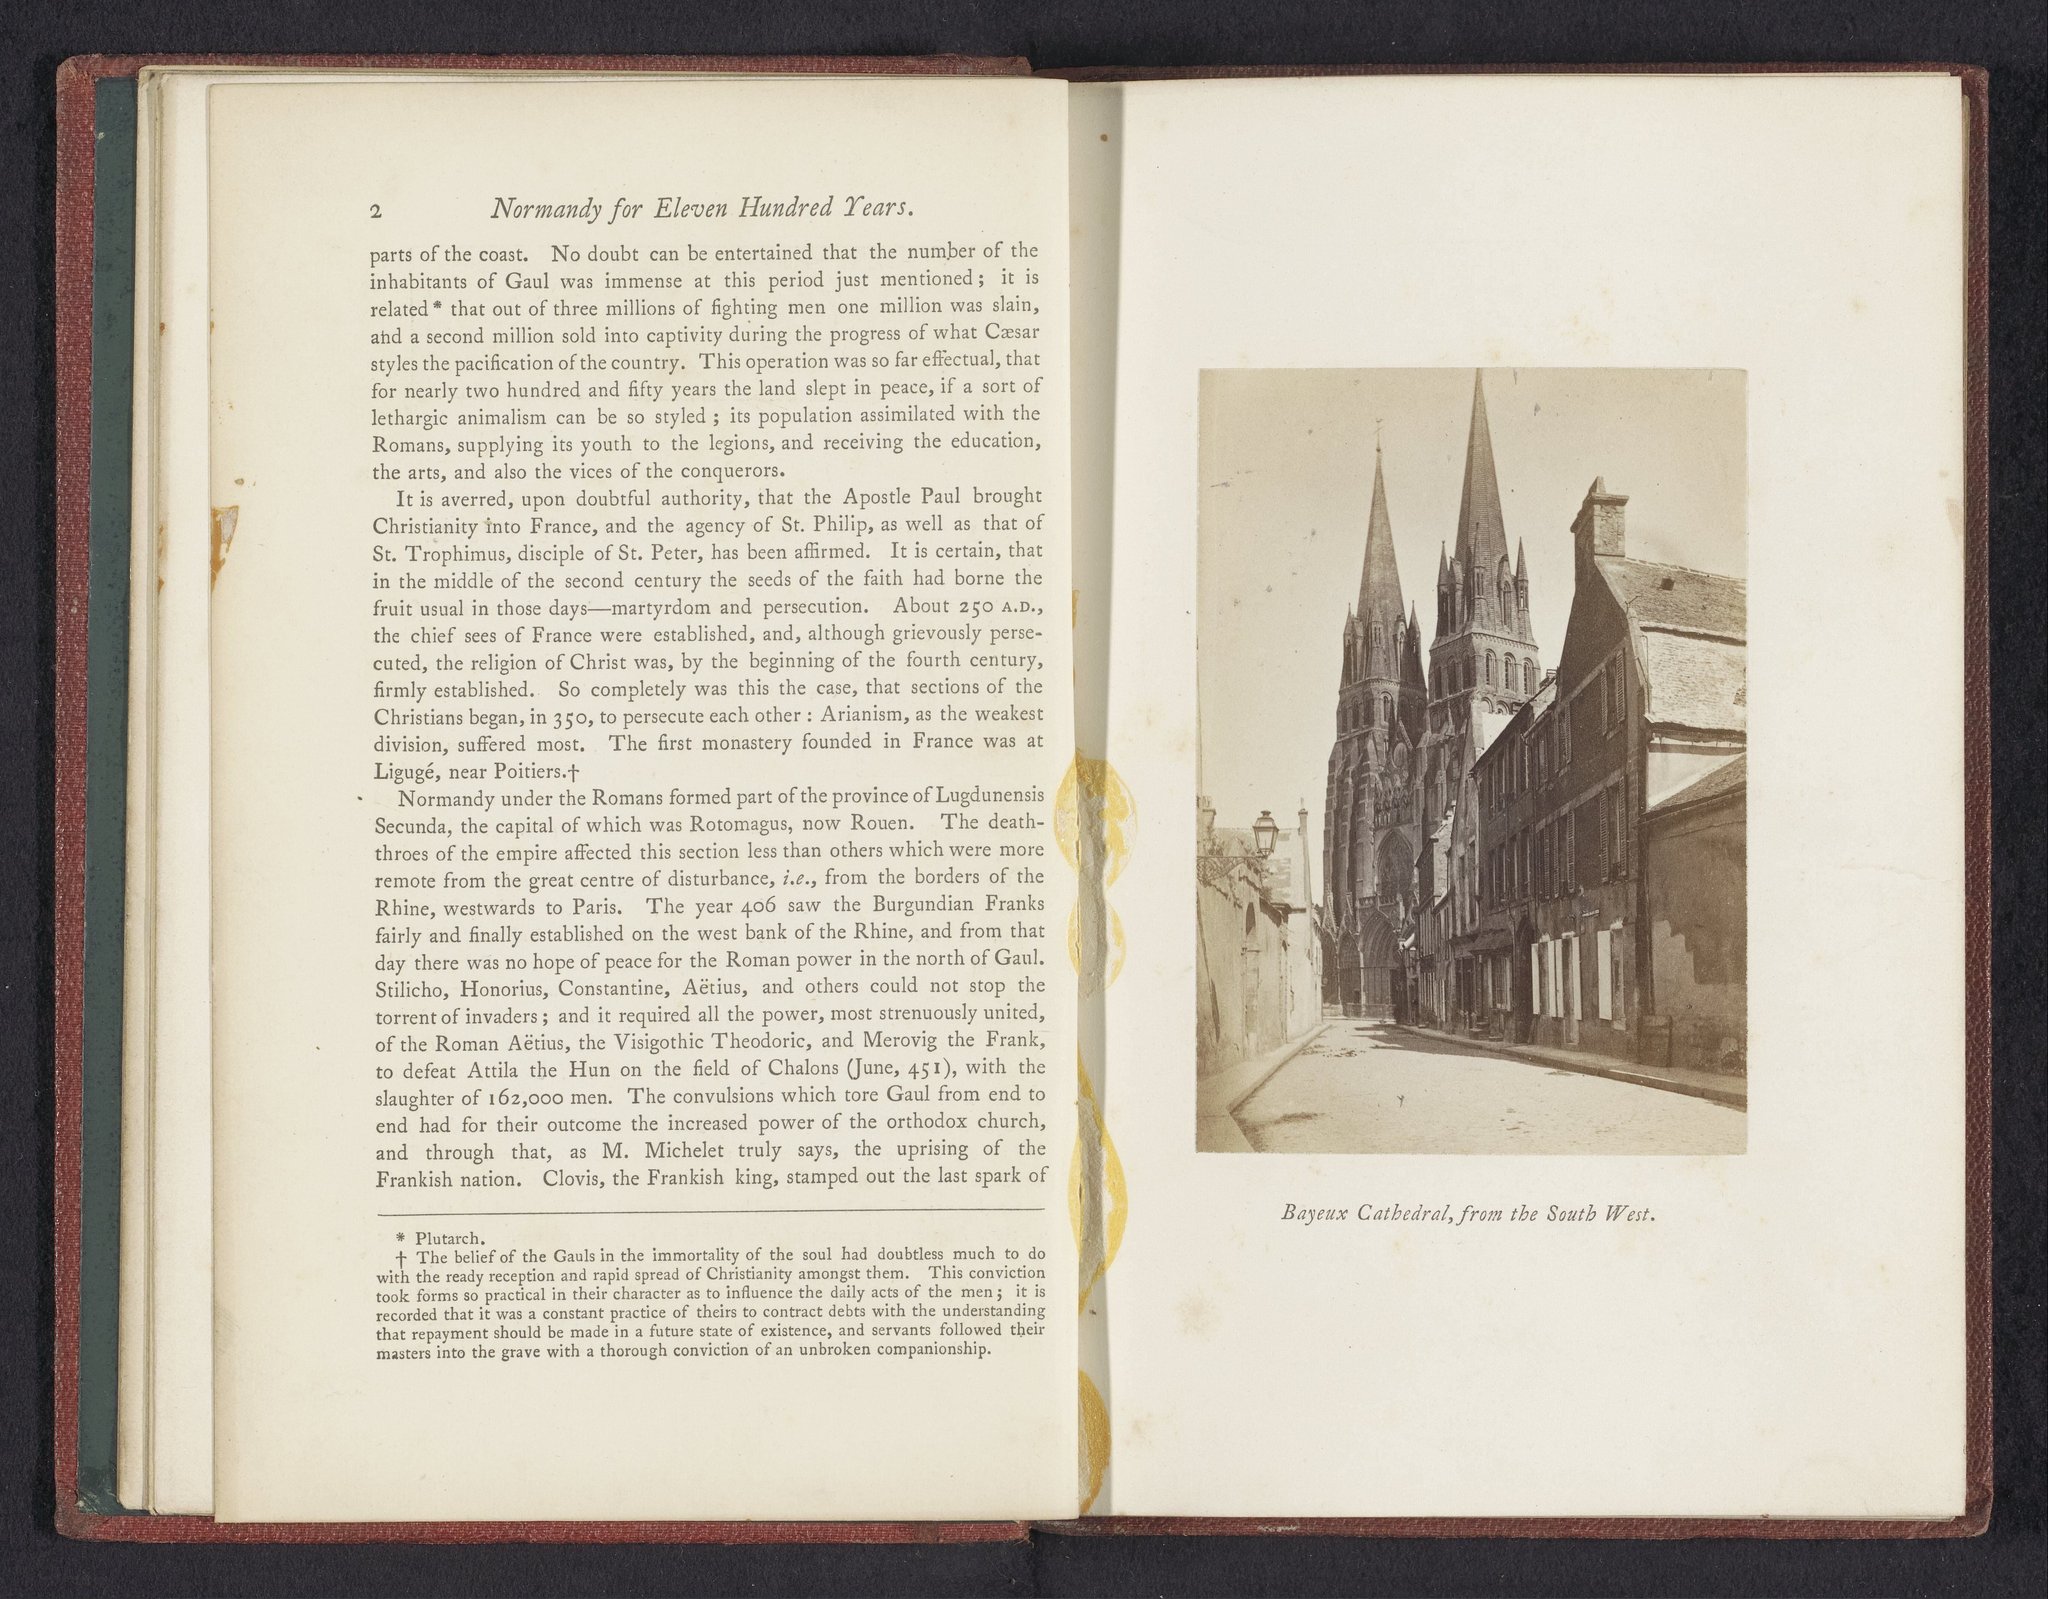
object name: page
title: Bayeux Cathedral, from the South West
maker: joseph cundall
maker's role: fotograaf, schrijver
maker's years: 1818-1895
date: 1855-1865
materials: photographic support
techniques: albumen print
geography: bayeux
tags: church (exterior), façade (of house or building)